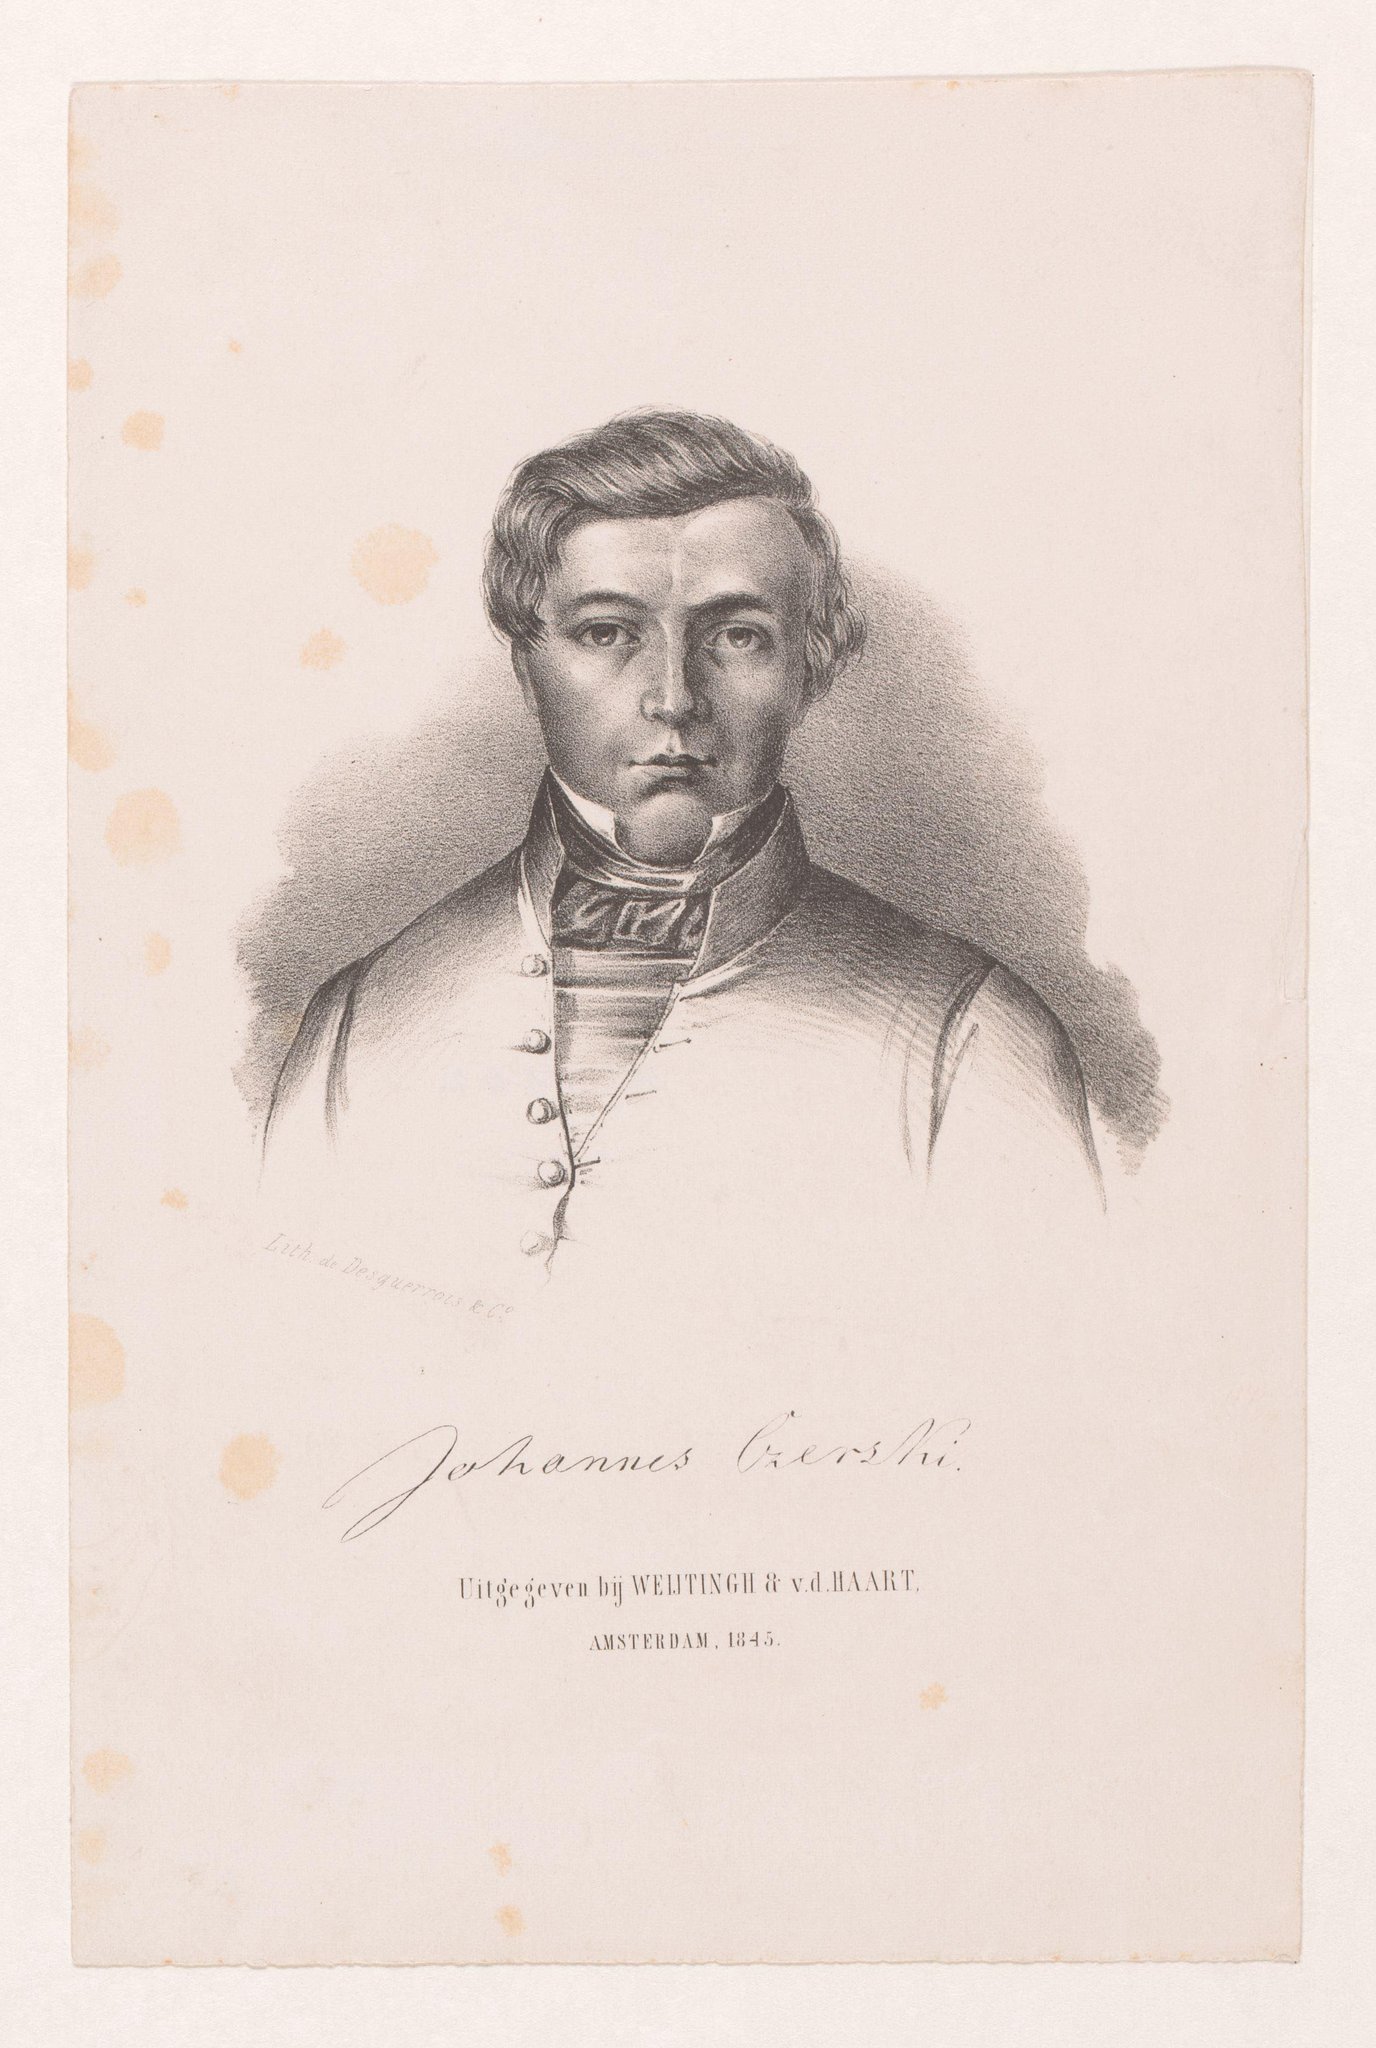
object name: print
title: Portret van Johannes Czerski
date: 1845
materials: paper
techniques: lithograph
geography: amsterdam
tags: clergyman, historical persons (+ head (and shoulders) (portrait))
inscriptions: collector's mark: Lugt 2228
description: De geportretteerde draagt een jas met opstaande kraag die deels is dichtgeknoopt. Onder het portret zijn signatuur.